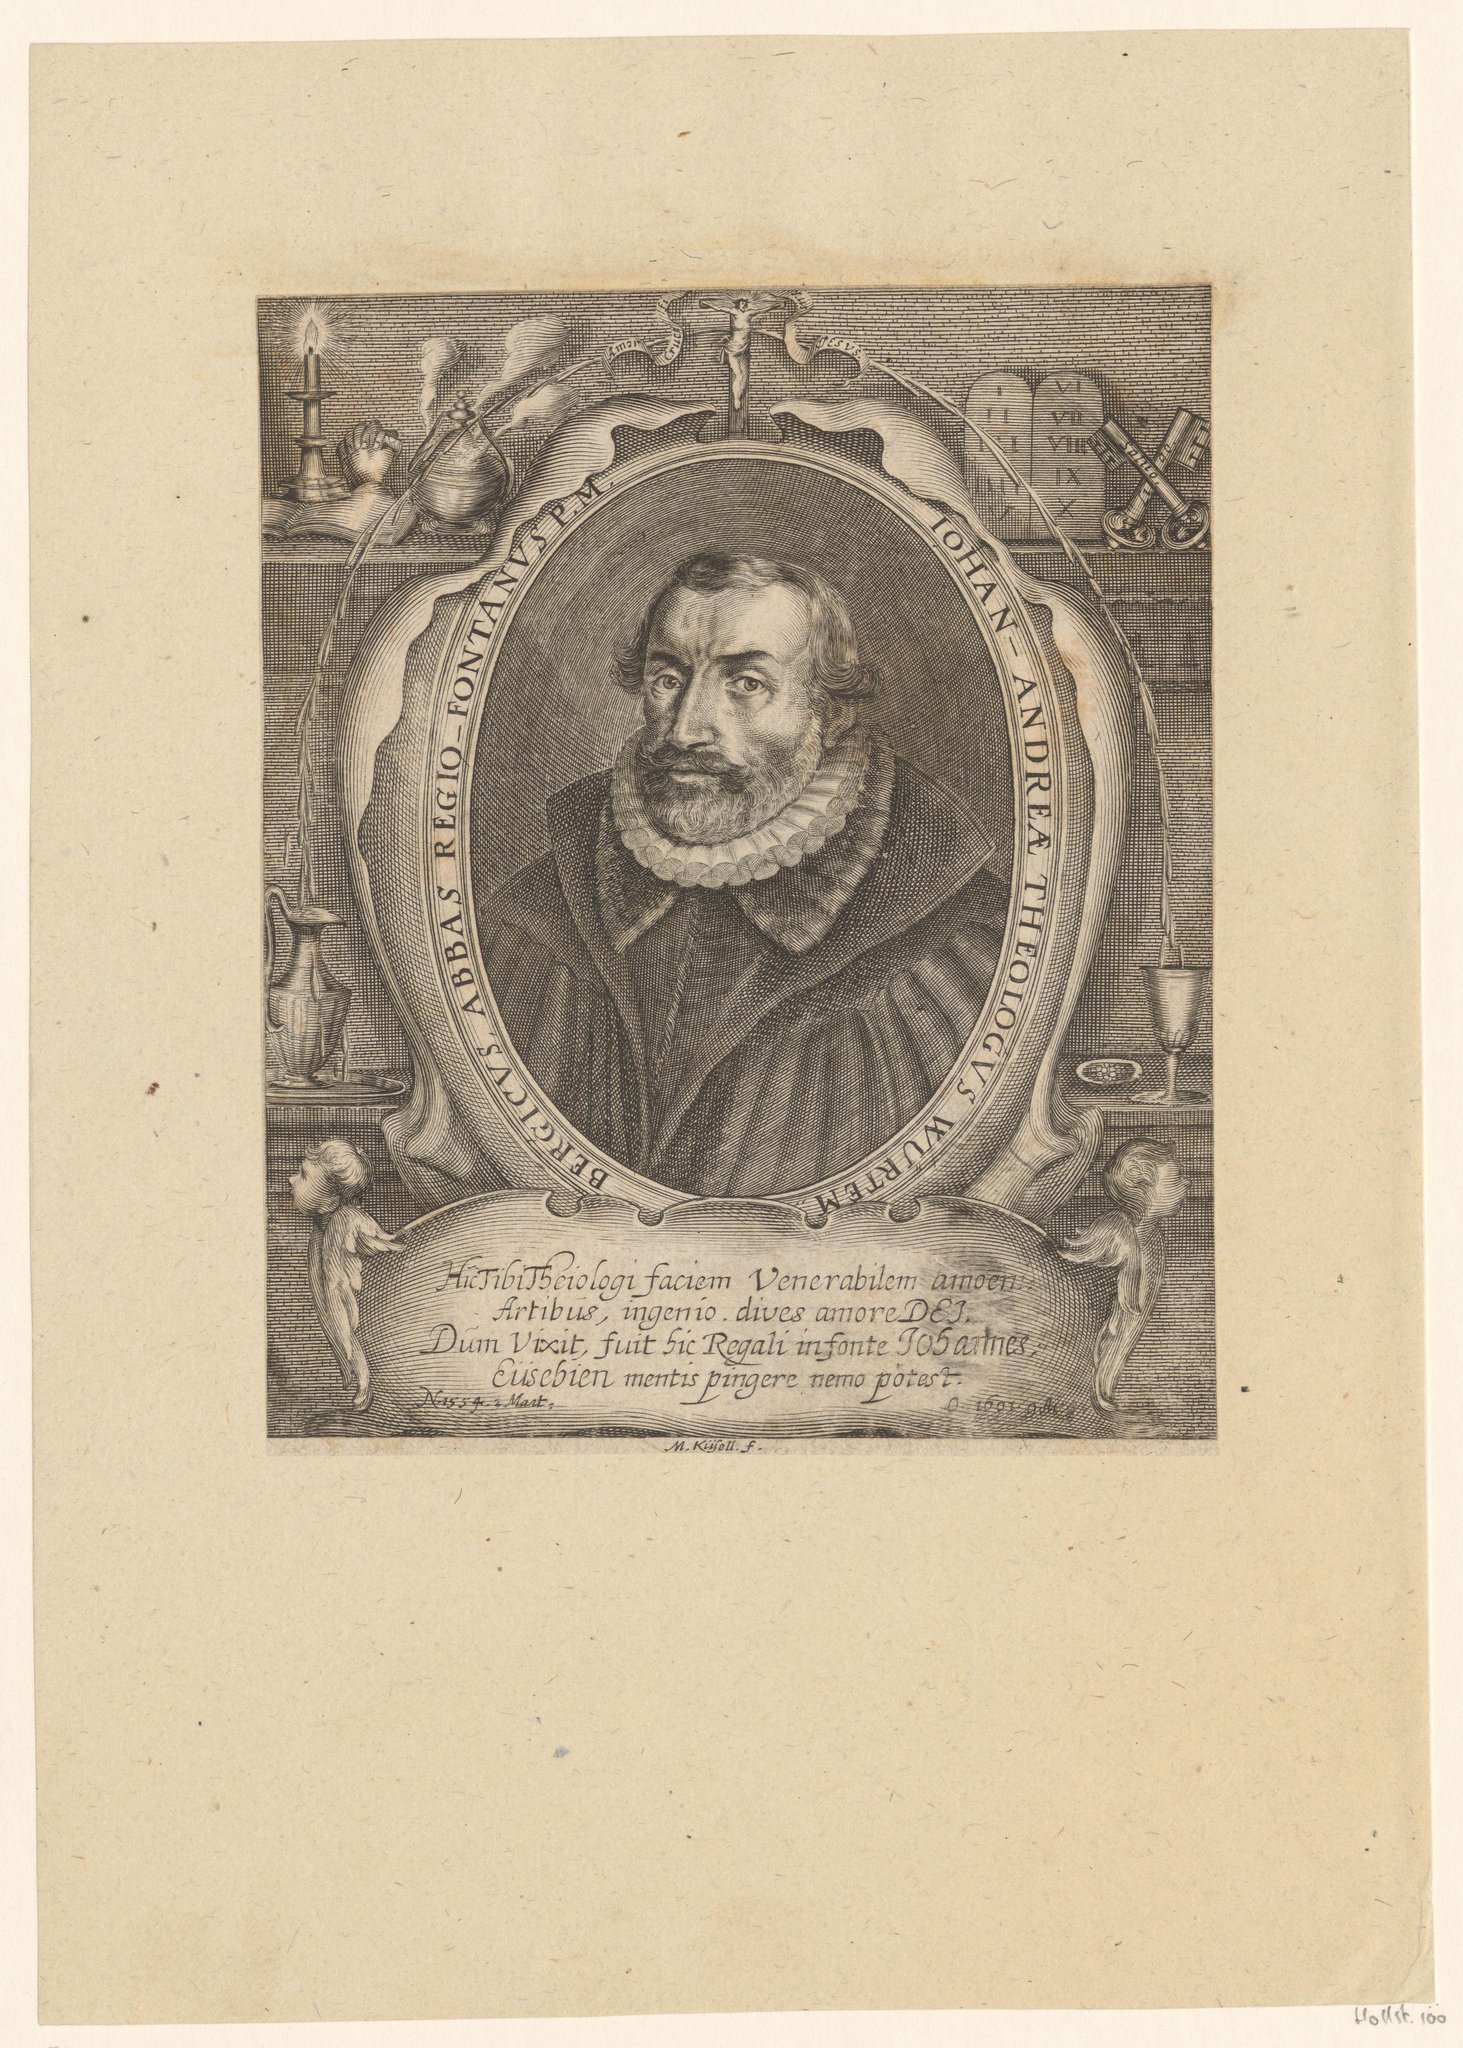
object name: print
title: Portret van Johann Valentin Andreae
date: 1601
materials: paper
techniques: engraving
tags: theologian, the eucharist ~ the fourth of the seven sacraments, censer, historical persons, the new tables of the law (exodus 34), the apostle peter, first bishop of rome; possible attributes: book, cock, (upturned) cross, (triple) crozier, fish, key, scroll, ship, tiara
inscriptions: collector's mark: Lugt 2228, collector's mark: Lugt 9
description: Tekst in het Latijn in de omlijsting en in de cartouche.